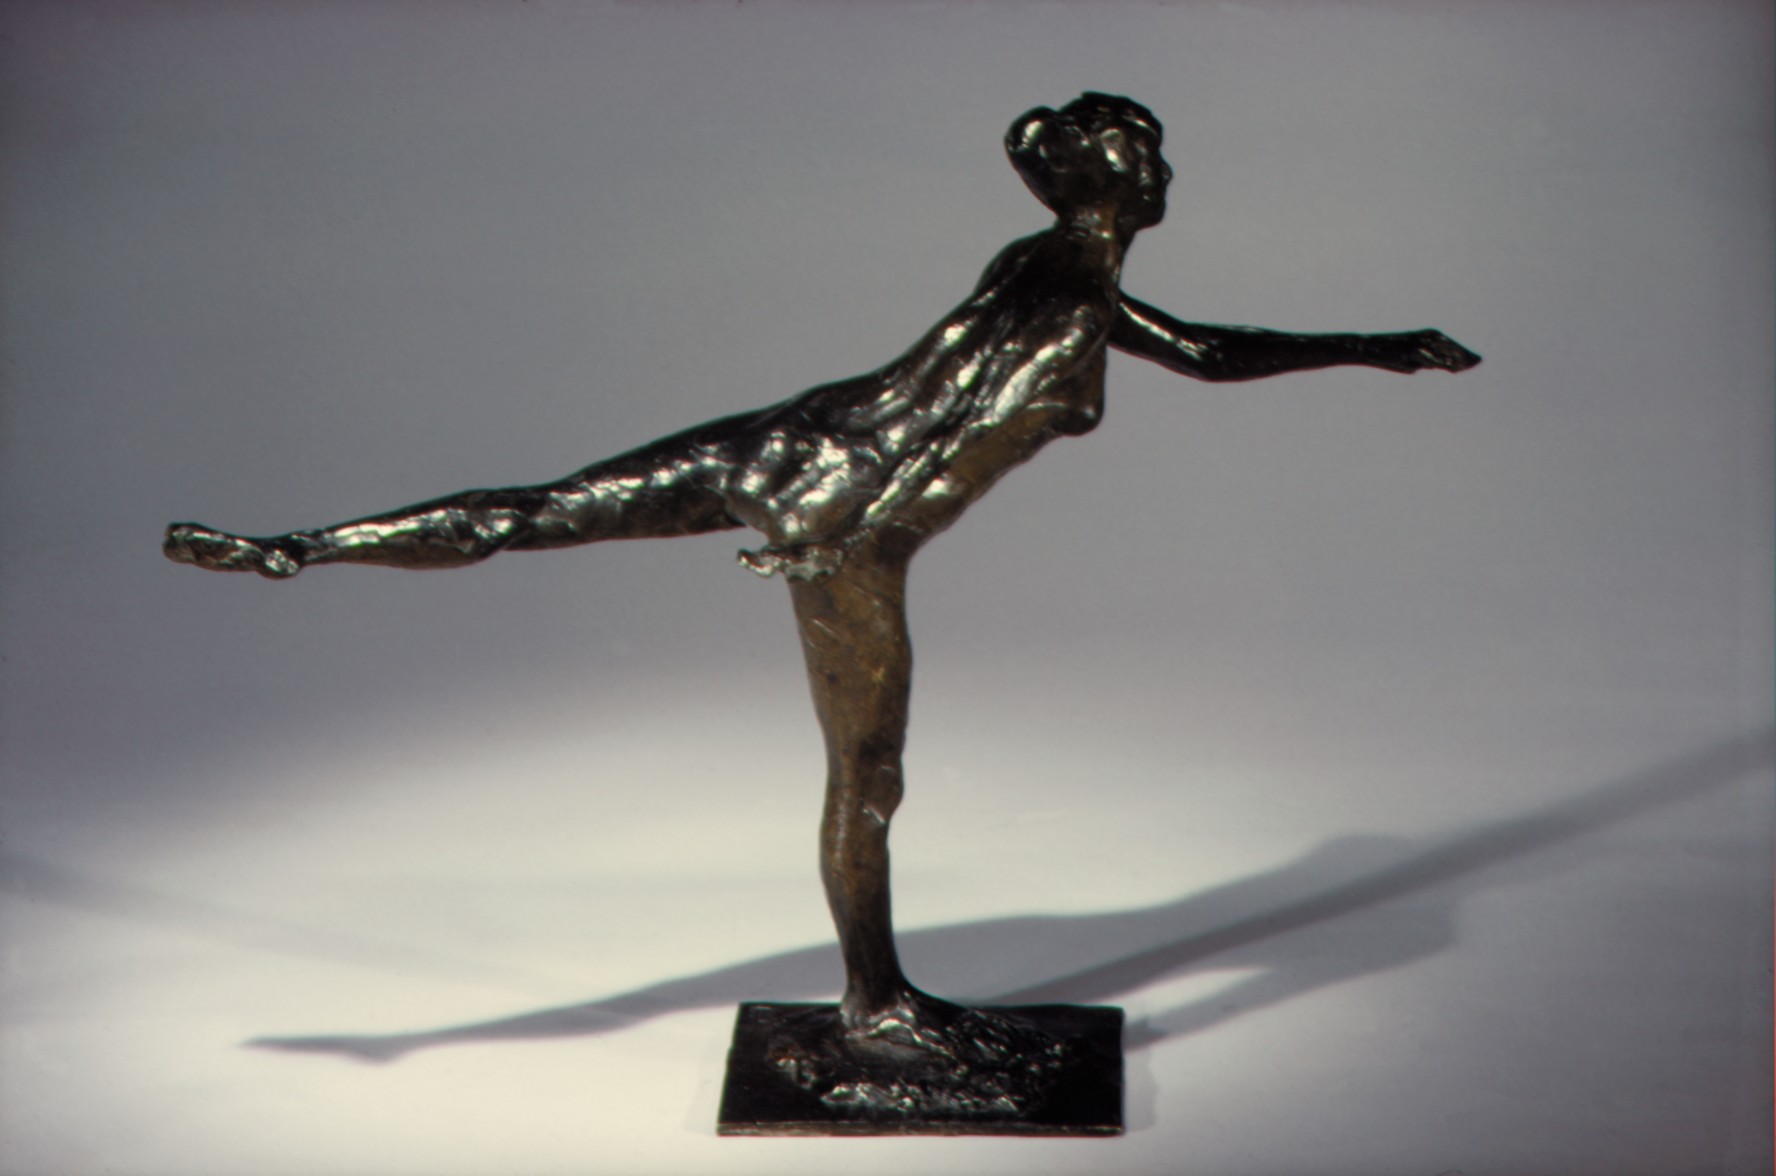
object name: statuette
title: Second Arabesque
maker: edgar degas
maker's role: artist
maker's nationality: french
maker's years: 1834-1917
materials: bronze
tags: female nudes,dancing,dancers,ballet